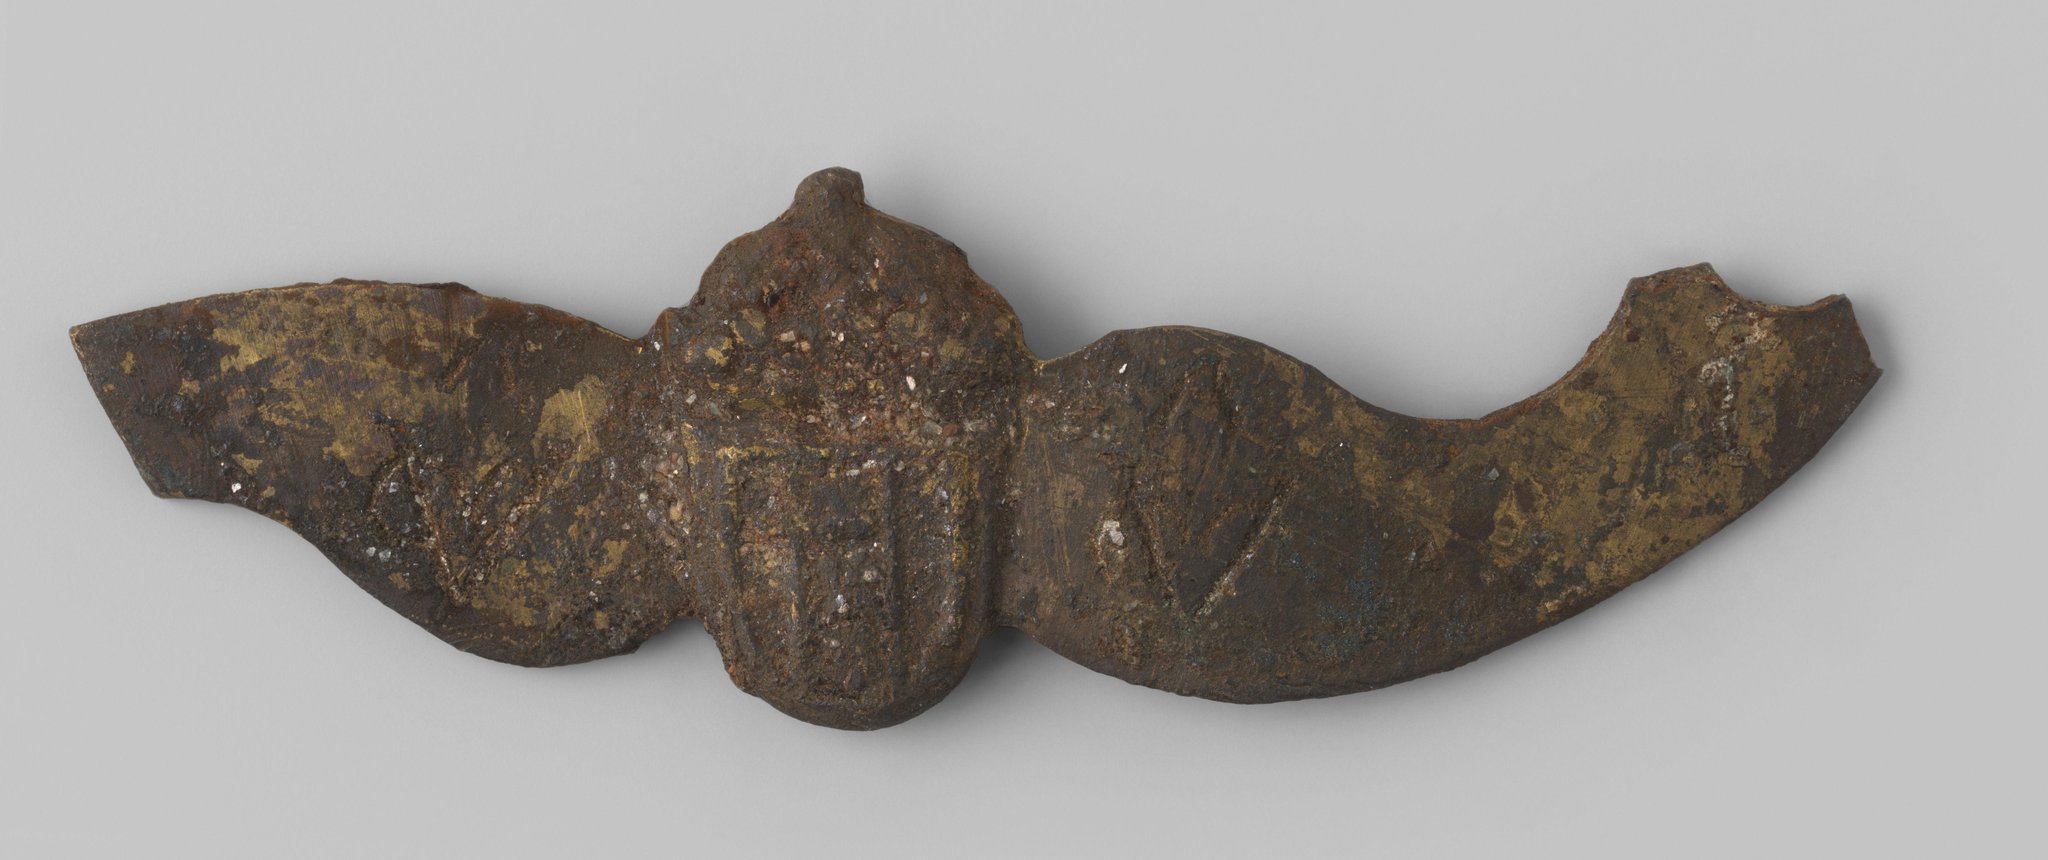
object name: schroefplaat, schroefblik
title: Fragment schroefplaat van een musket uit het wrak van de Oost-Indiëvaarder Hollandia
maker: Anonymous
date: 1700-1743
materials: copper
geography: netherlands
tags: verenigde oostindische compagnie, hollandia (schip), annet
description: Fragm, id. NG 1980-27H3069, right eye broken off, side plate.